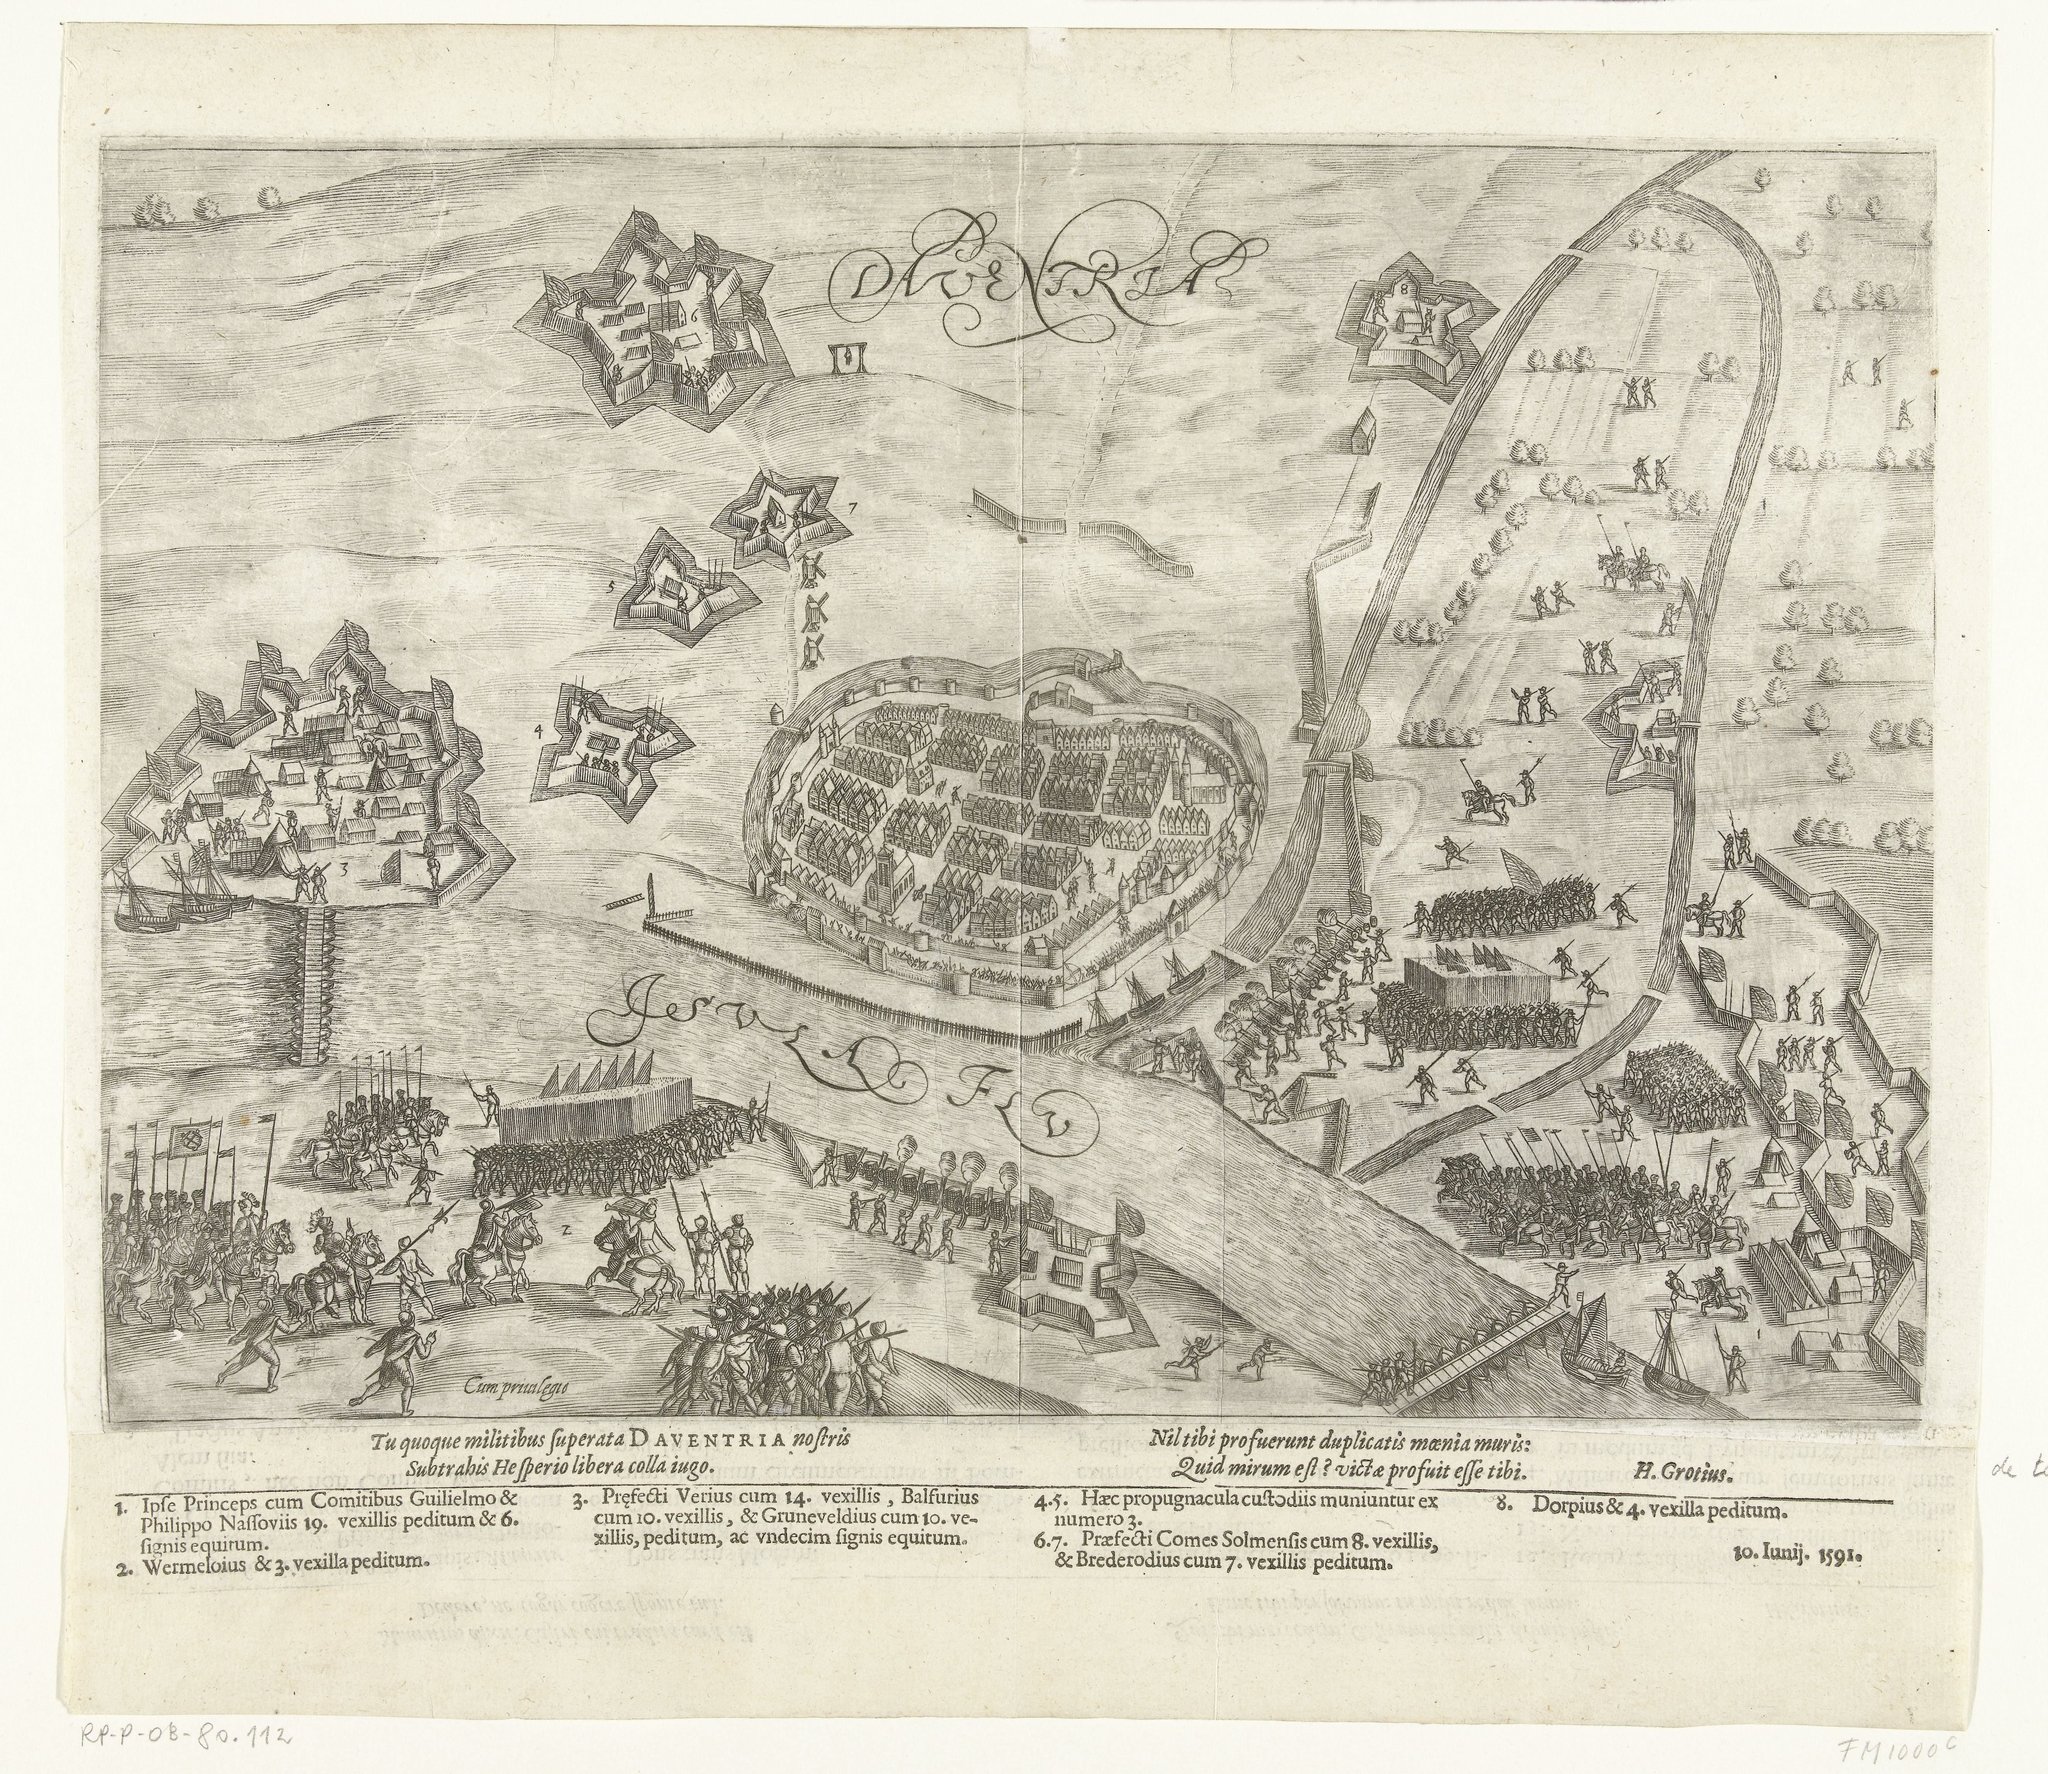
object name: history print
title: Beleg en inname van Deventer, 1591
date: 1600-1601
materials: paper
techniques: engraving, letterpress printing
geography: northern netherlands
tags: improvised bridge, temporary bridge ~ military engineering, capture of city (after the siege), deventer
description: De plaat is later gebruikt als illustratie in: J.J. Orlers, Den Nassauschen Lauren-Crans: Beschrijvinghe ende af-beeldinge van alle de victorien ... die Godt Almachtich de ... Staten der Vereenichde Nederlanden verleent heeft, deur het wijs ende clouck beleyt des Hooch-ghebooren Fursts Maurits van Nassau, J.J. Orlers en H. van Haestens, Leiden 1610, fol. 80/81.